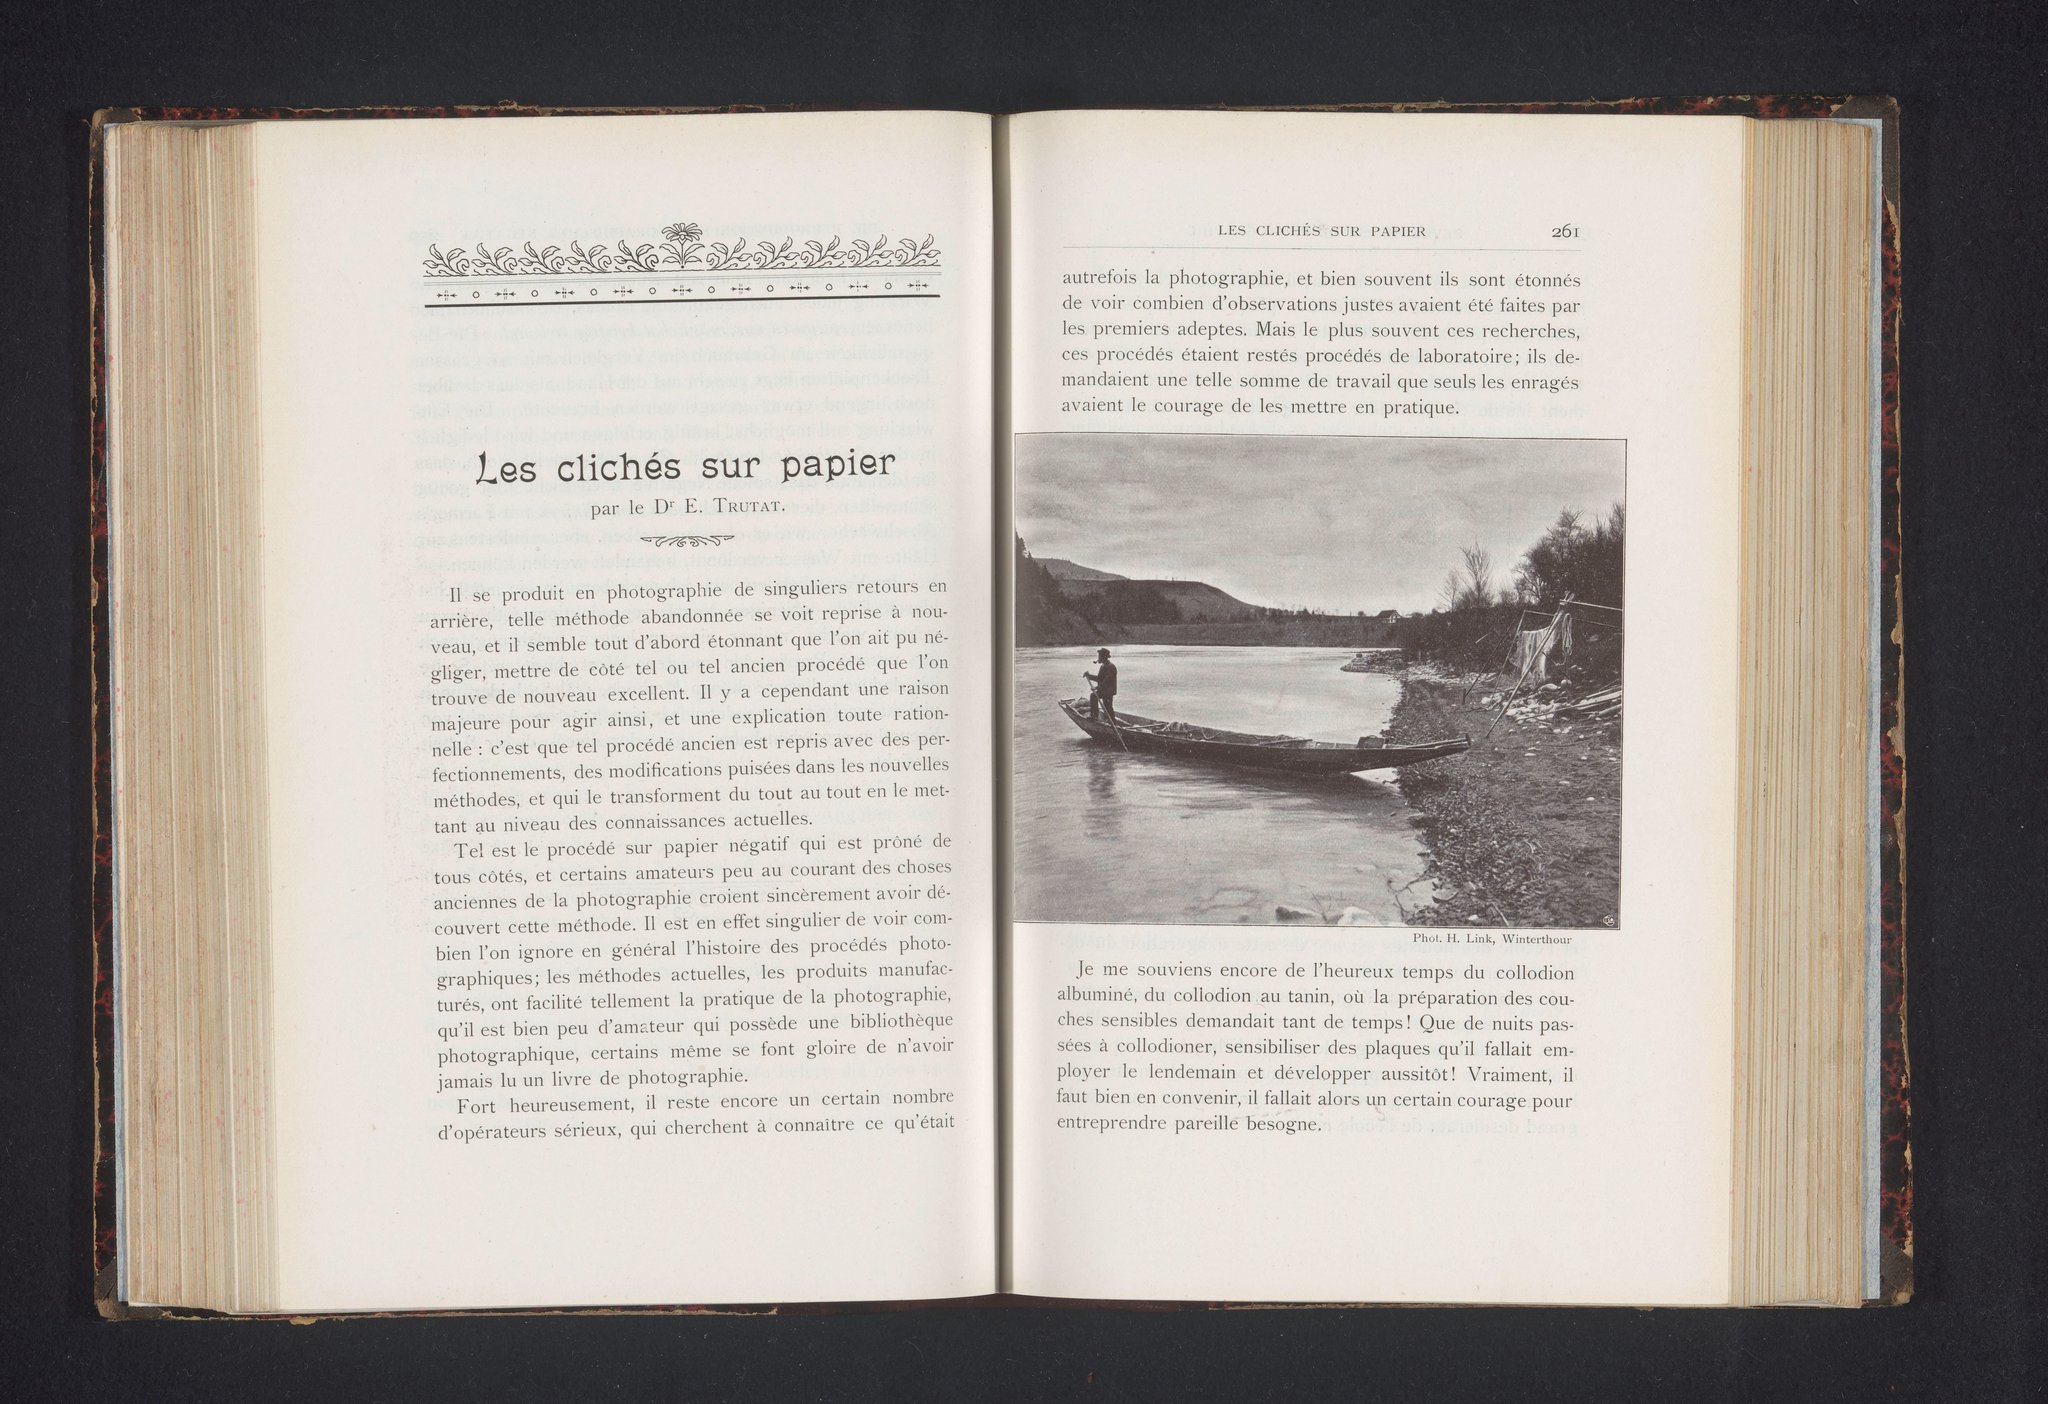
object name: photomechanical print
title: Rivier met een man in een boot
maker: hermann linck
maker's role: fotograaf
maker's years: 1866-1938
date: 1897-1902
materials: paper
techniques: autotype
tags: river, rowing-boat, canoe, etc.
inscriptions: monogram: ‘C. Cie’